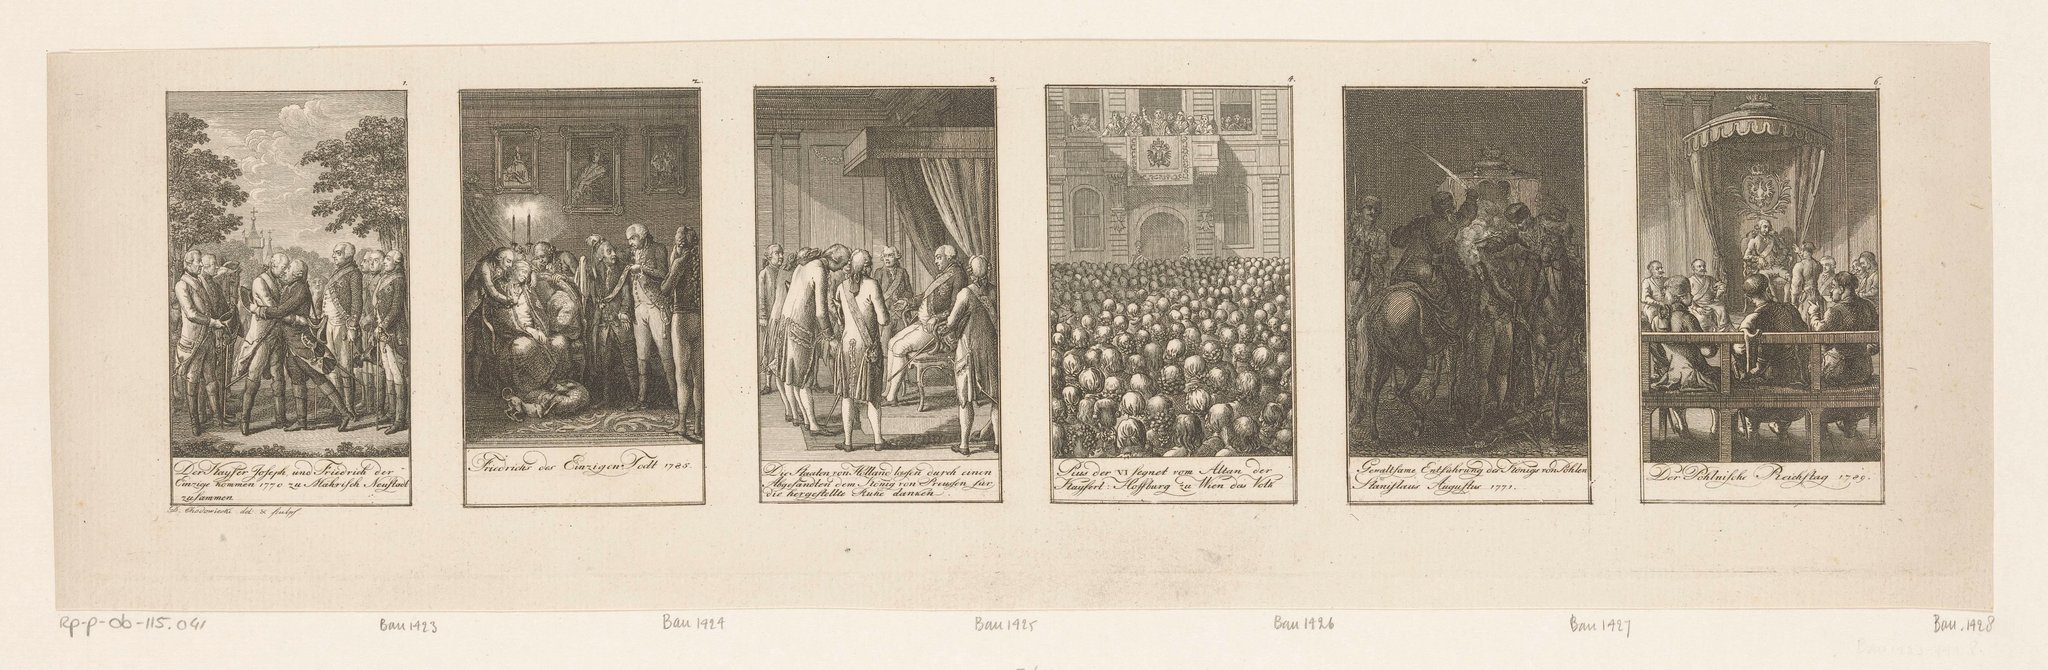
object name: print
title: Zes voorstellingen uit de nieuwe geschiedenis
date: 1789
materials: paper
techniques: etching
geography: gotha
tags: history, deathbed, embracing each other, kissing, coronation of a ruler, robbery, pope, lower house, parliament, chamber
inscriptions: collector's mark: Lugt 2228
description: Vervaardigd voor 'der neuen Geschichte'. Prent gebruikt voor: Gothaischer Hof Kalender zum Nutzen und Vergnügen eingerichtet auf das Jahr 1790. Gotha: C. W. Ettinger, [1789].